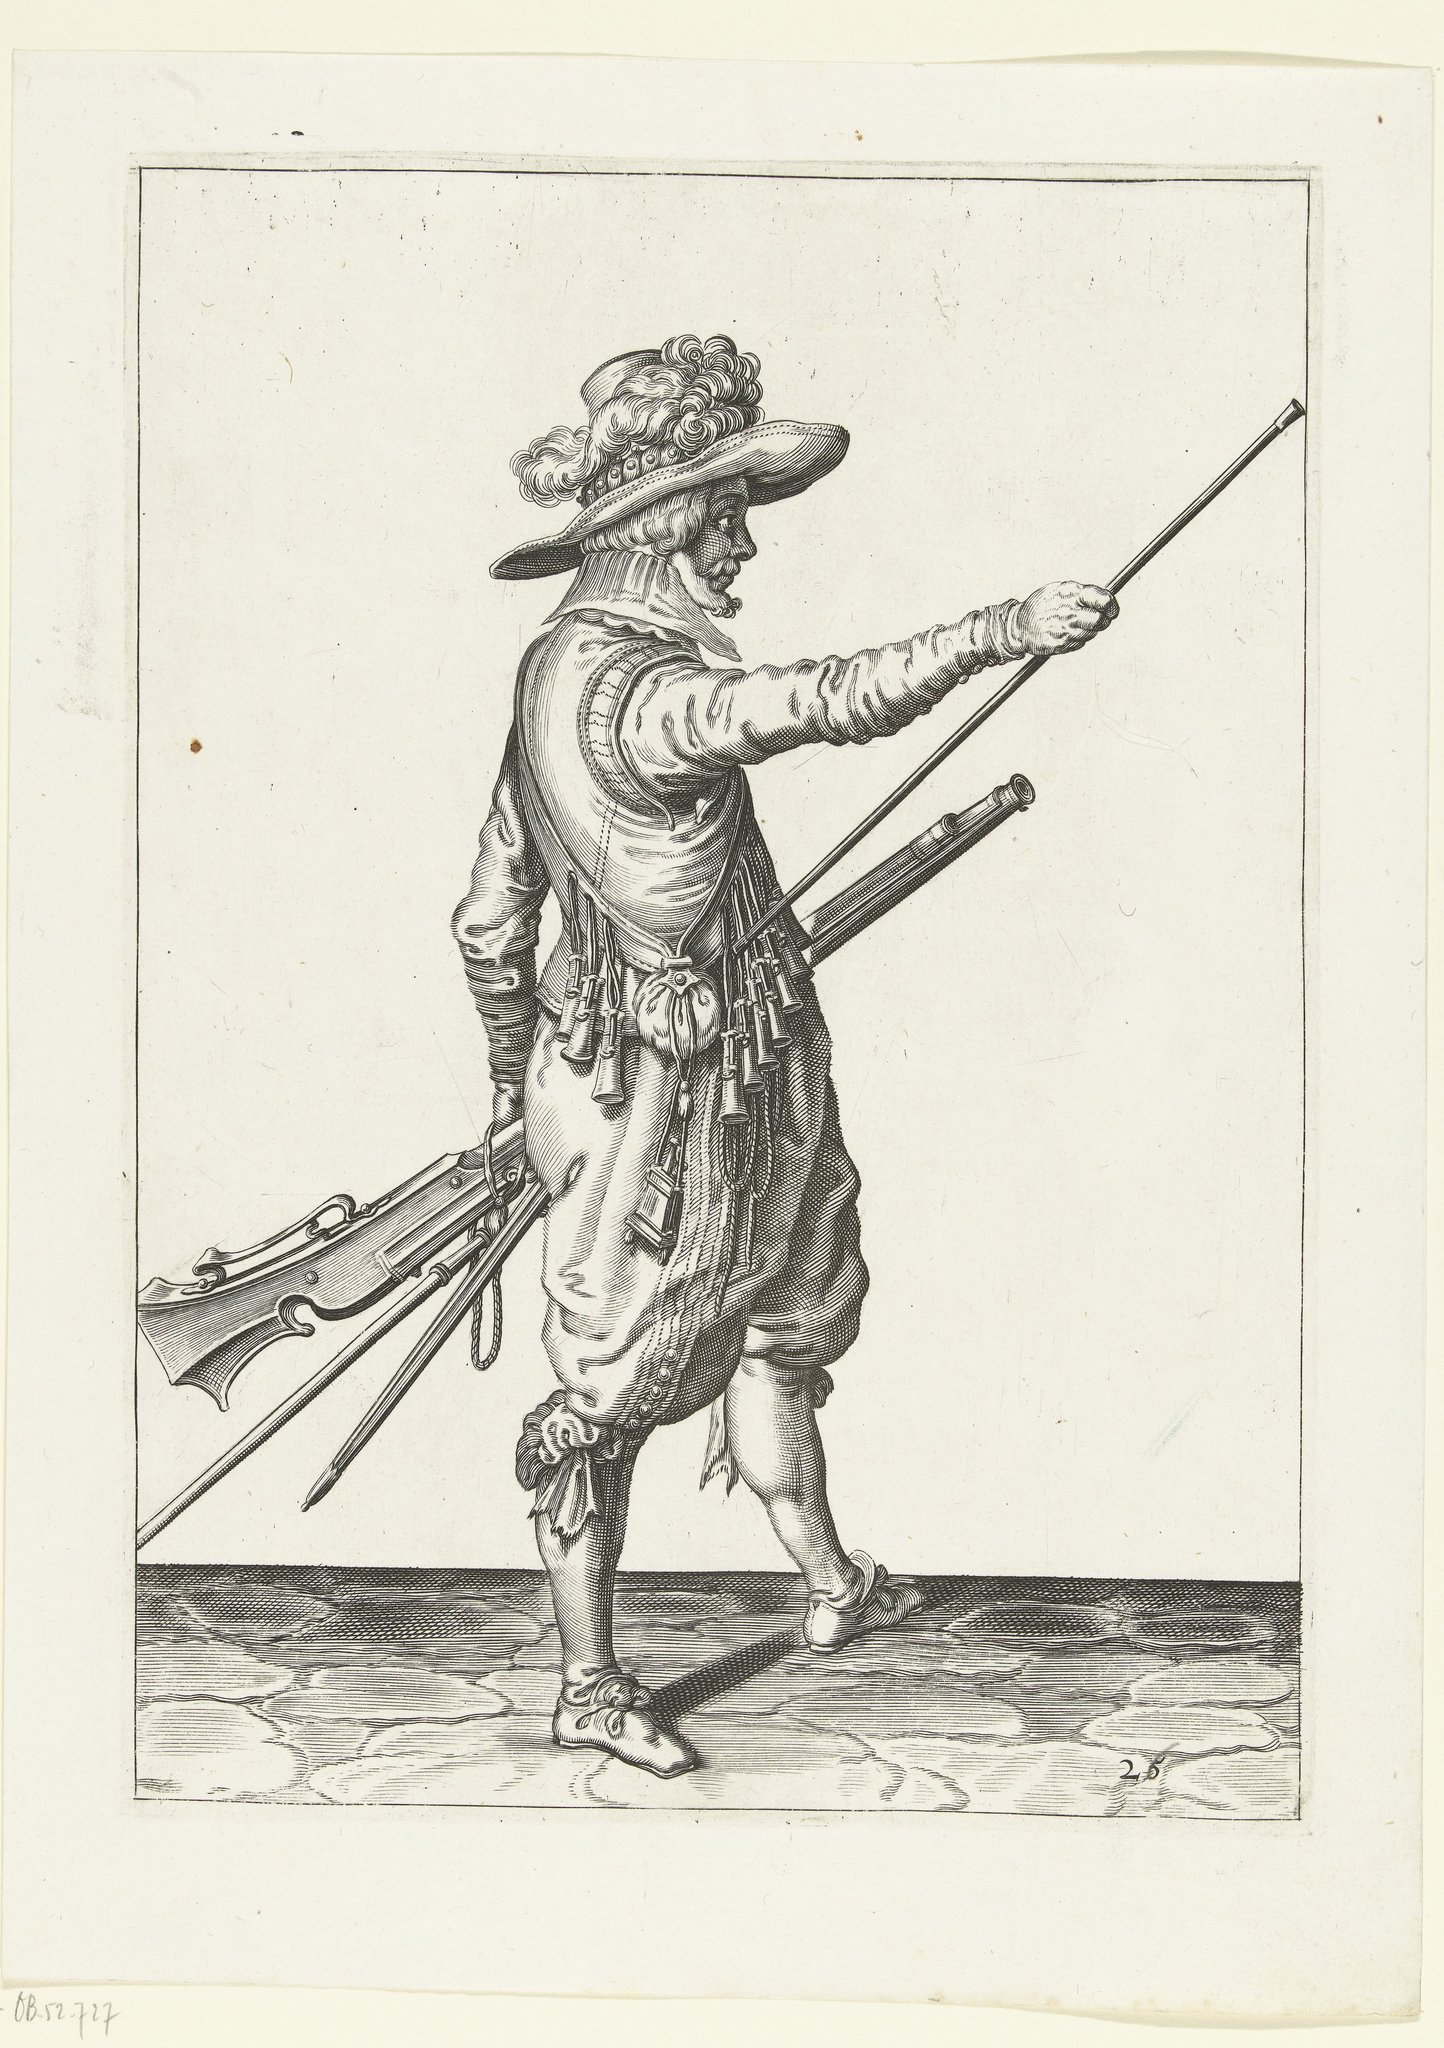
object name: print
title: Soldaat met een musket die zijn rechterhand naar het uiteinde van zijn laadstok schuift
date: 1597-1607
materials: paper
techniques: engraving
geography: netherlands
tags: manoeuvre ~ military training, firearms: rifle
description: Een soldaat, ten voeten uit, naar rechts, die met zijn linkerhand bij zijn linkerdijbeen een musket (een bepaald type vuurwapen) vasthoudt en zijn rechterhand naar het uiteinde brengt van zijn laadstok, die hij tegen zijn rechterzij laat steunen. In zijn linkerhand behalve het musket ook een lont; aan zijn linkerpols een furket (musketvork). Deze prent is onderdeel van de reeks van 43 genummerde prenten van musketiers uit de Wapenhandelinghe.